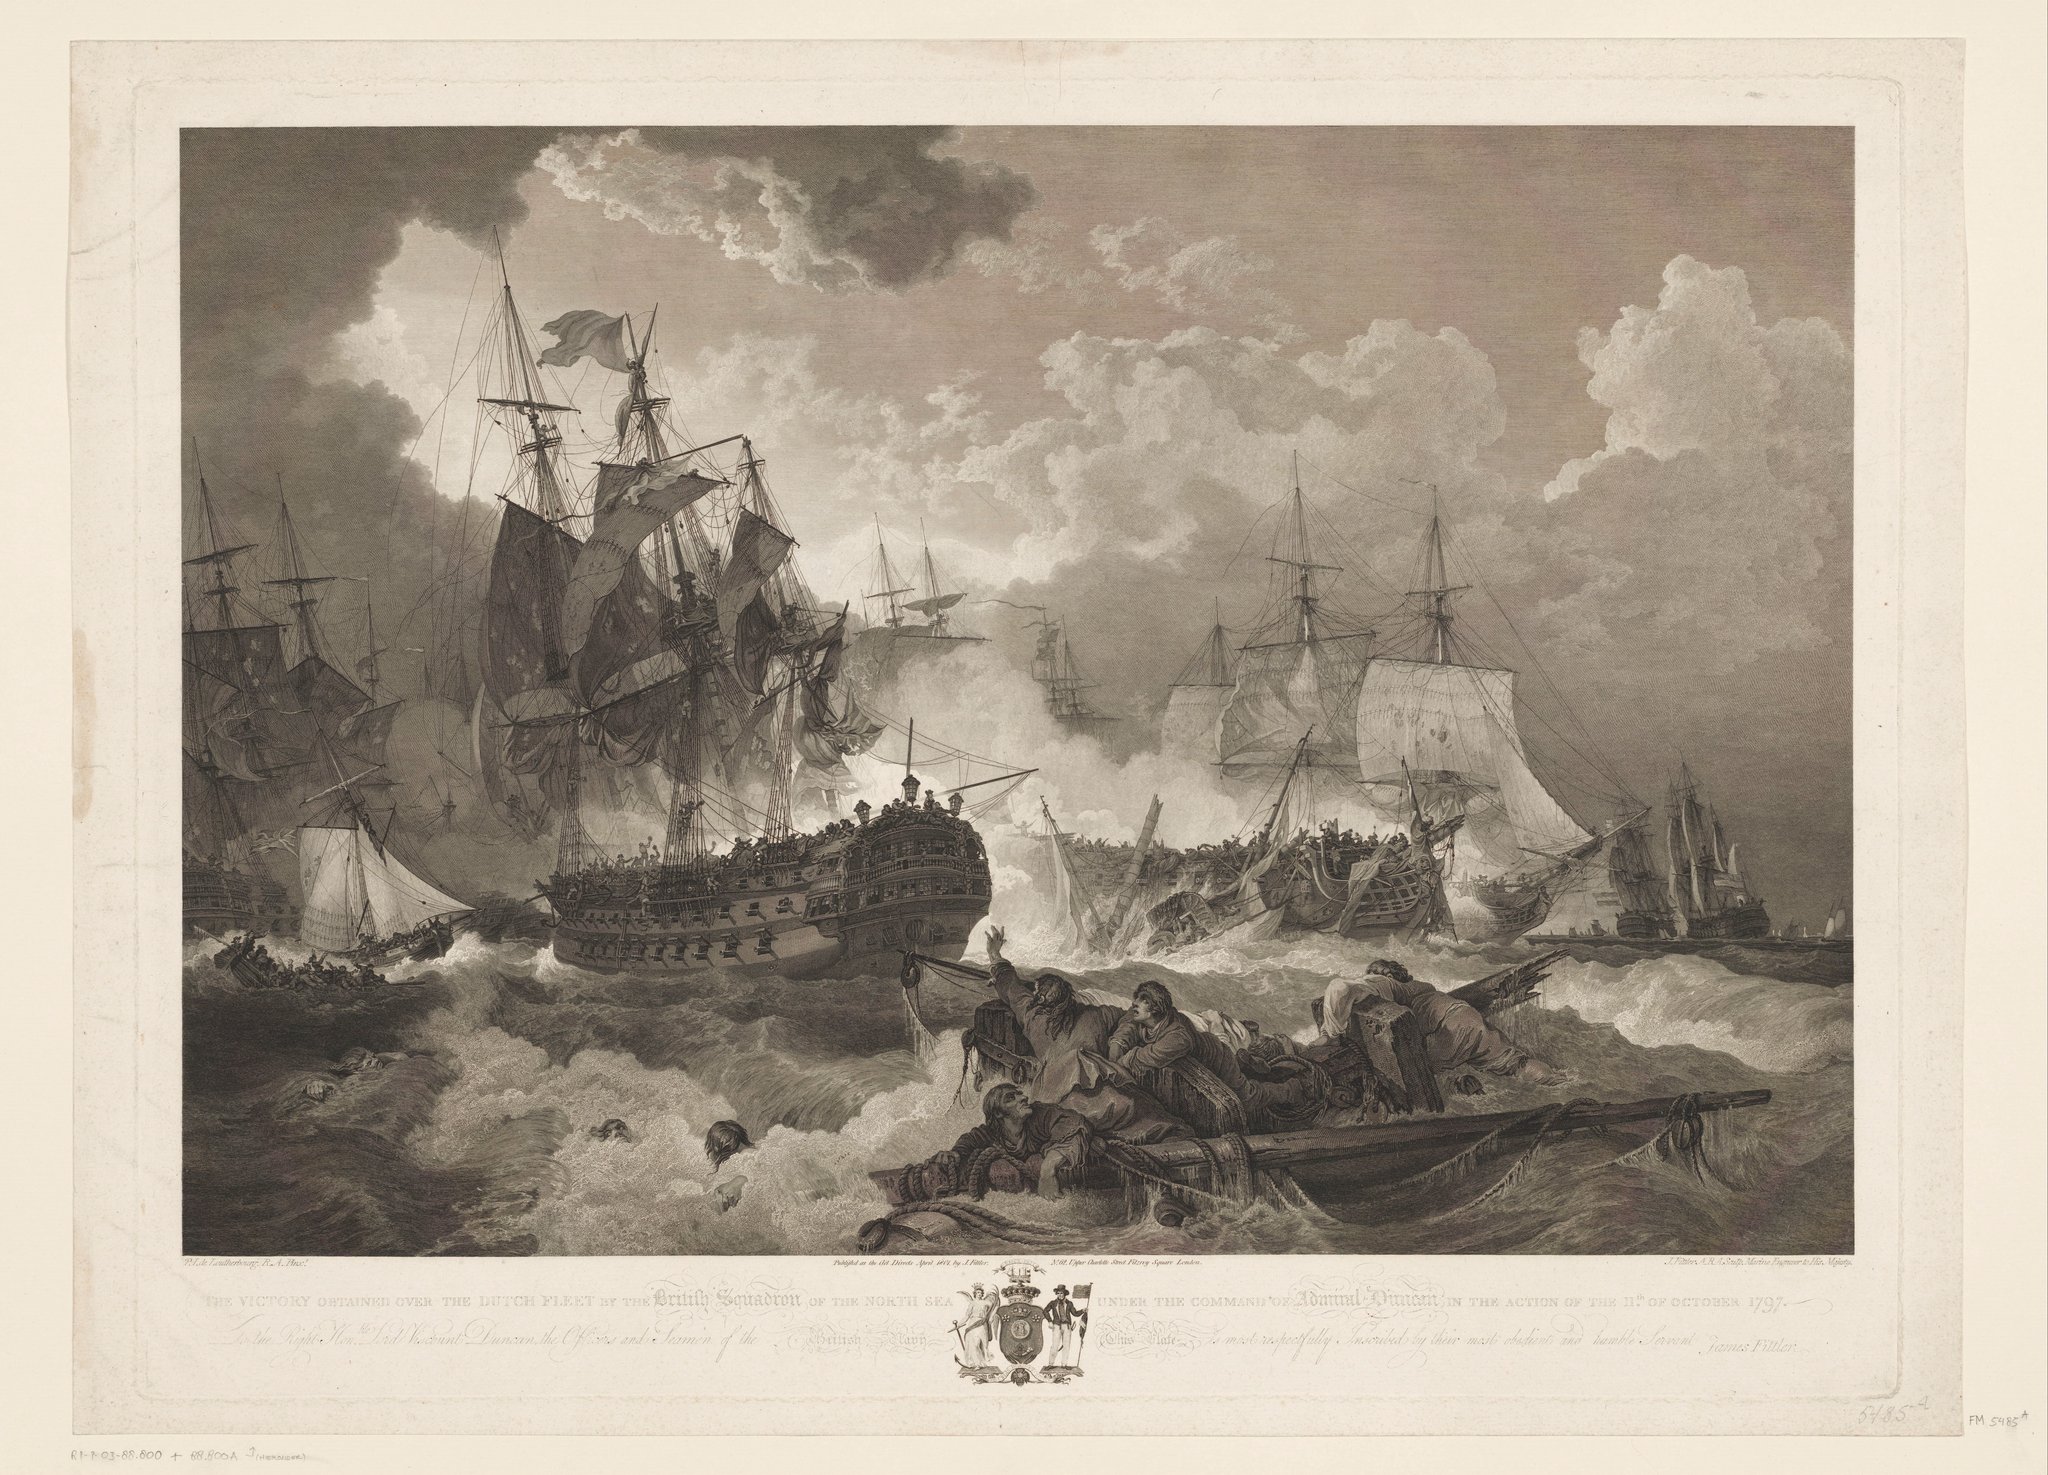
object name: print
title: The Victory obtained over the Dutch Fleet by the British Squadron of the North Sea under the command of Admiral Duncan in the action of the 11.th of October 1797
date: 1801-1804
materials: paper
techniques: engraving, etching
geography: england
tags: adam duncan (burggraaf van duncan), paris, jan willem de winter, battle (+ naval force), battle of camperdown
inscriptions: collector's mark: Lugt 2165, collector's mark: Lugt 2228, collector's mark: Lugt 12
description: Britse overwinning in de zeeslag bij Kamperduin op 11 oktober 1797 tussen de Bataafse vloot onder bevel van vice-admiraal Jan Willem de Winter en een Britse vloot onder admiraal Adam Duncan. Links het Britse schip the Venerable, rechts daarvan het Nederlandse schip de Vrijheid zonder mast. Op de voorgrond klampen drenkelingen zich vast aan wrakhout. Bij de prent behoort ook een sleutel.